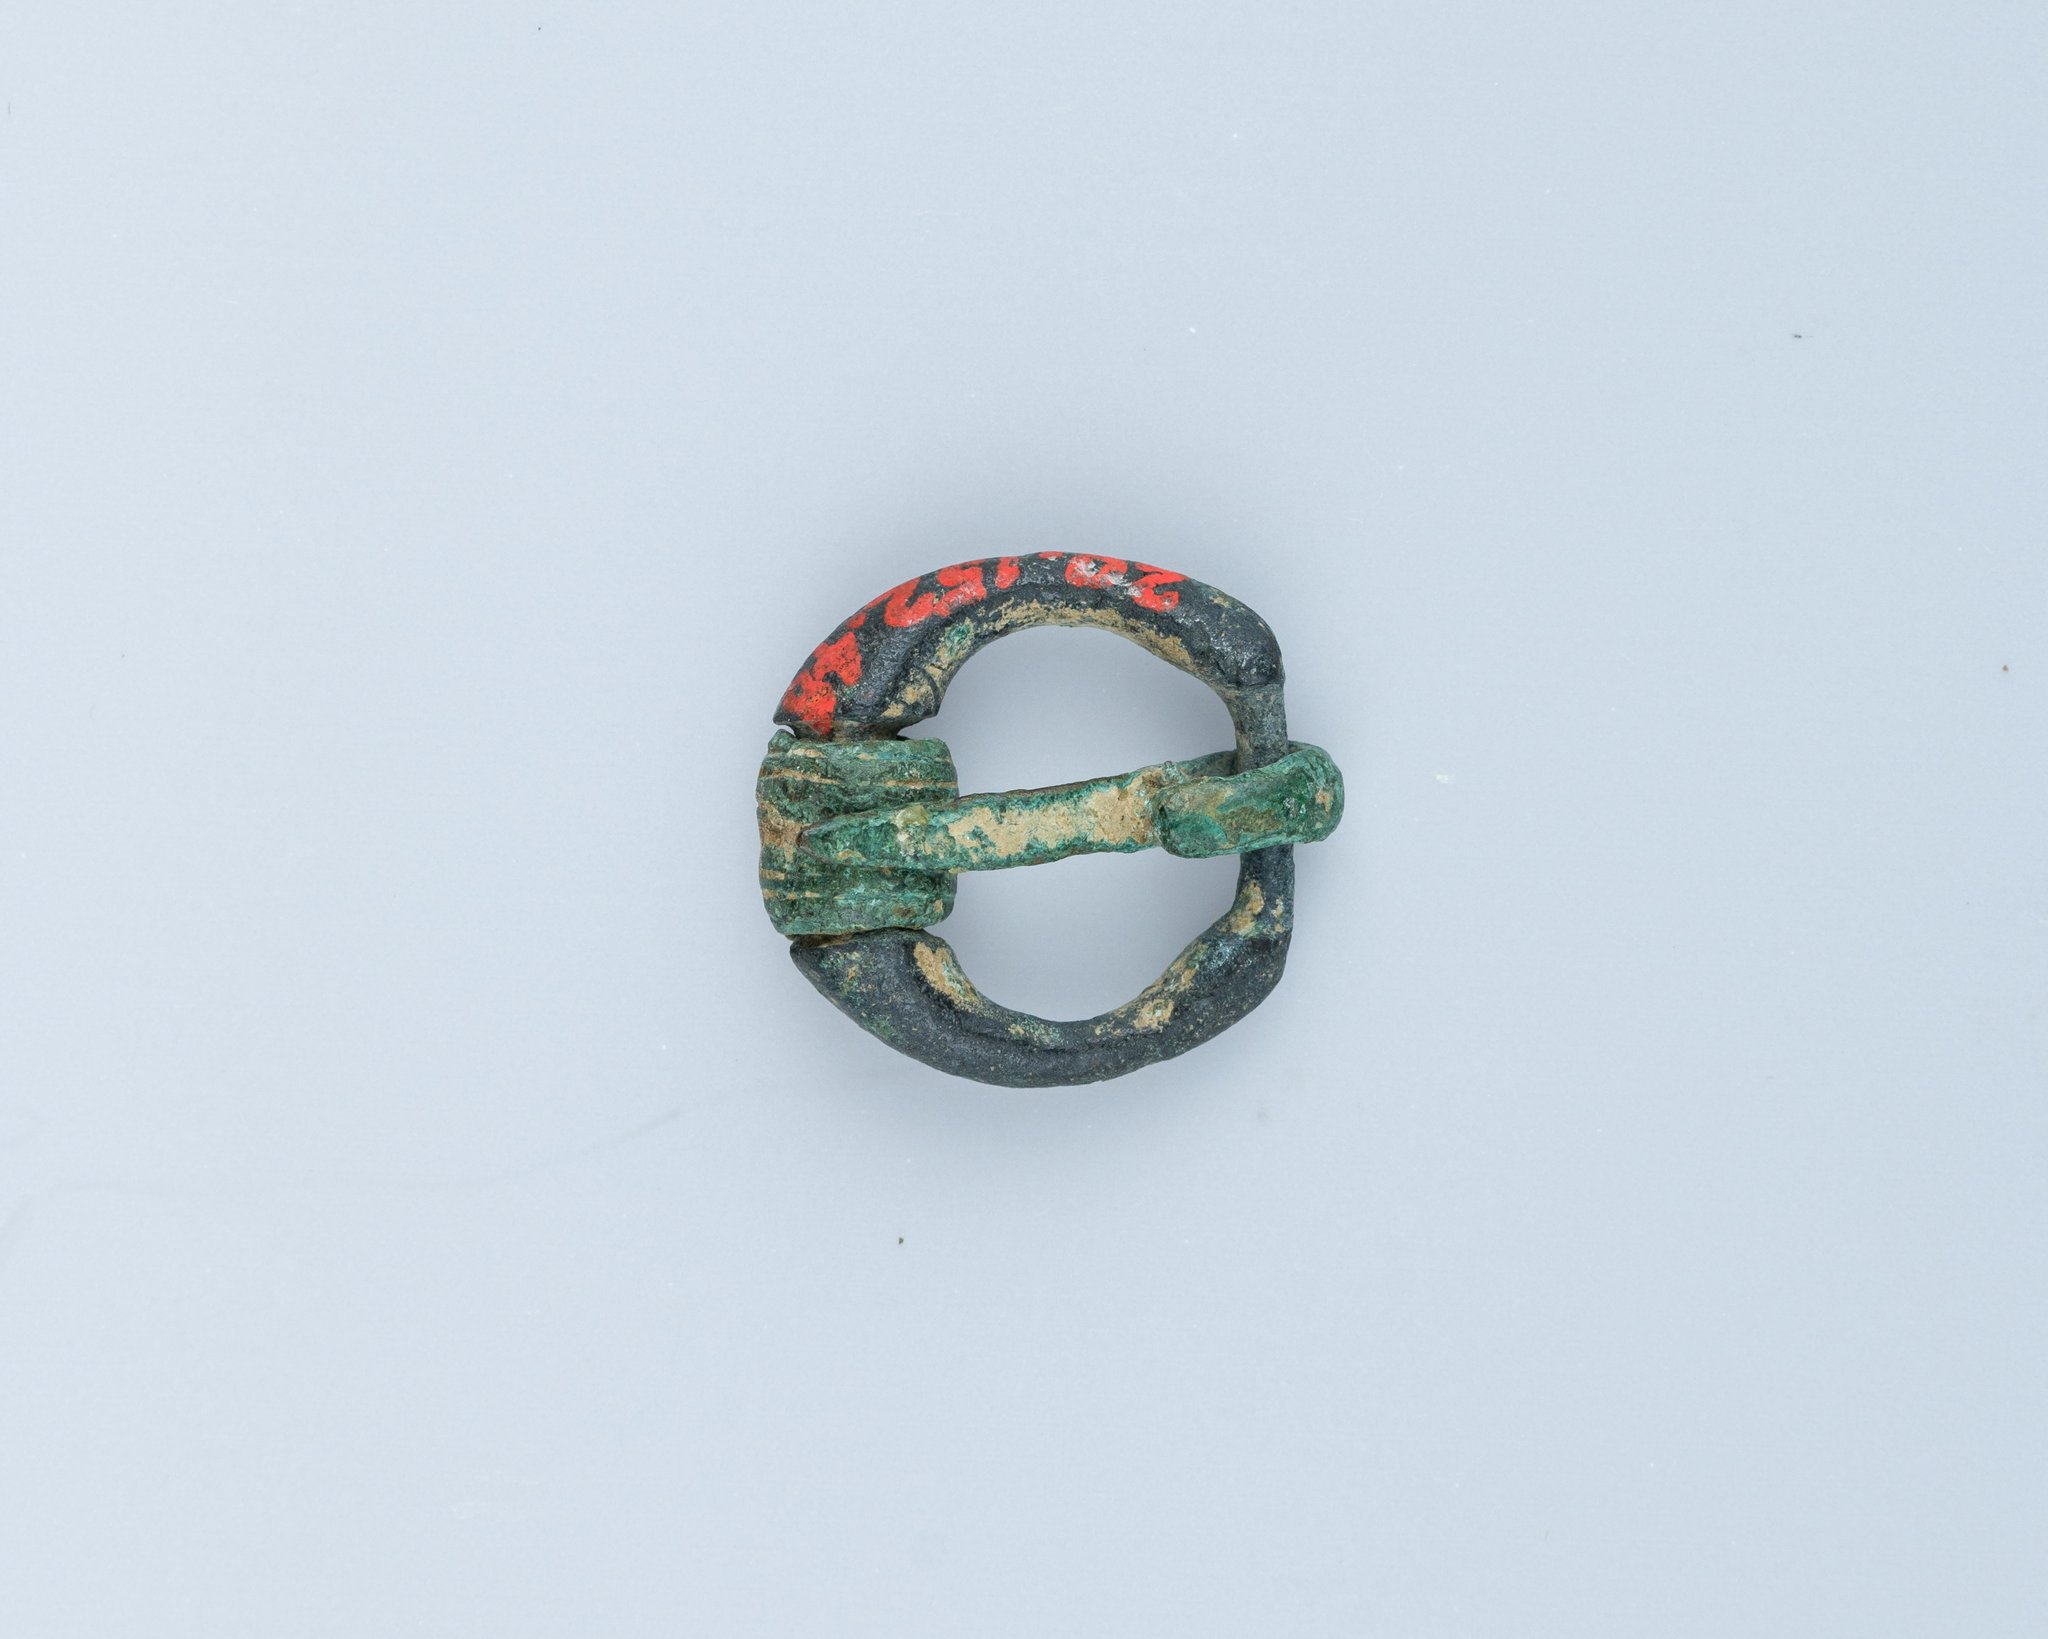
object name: buckle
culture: spanish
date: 201-400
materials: bronze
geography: spain